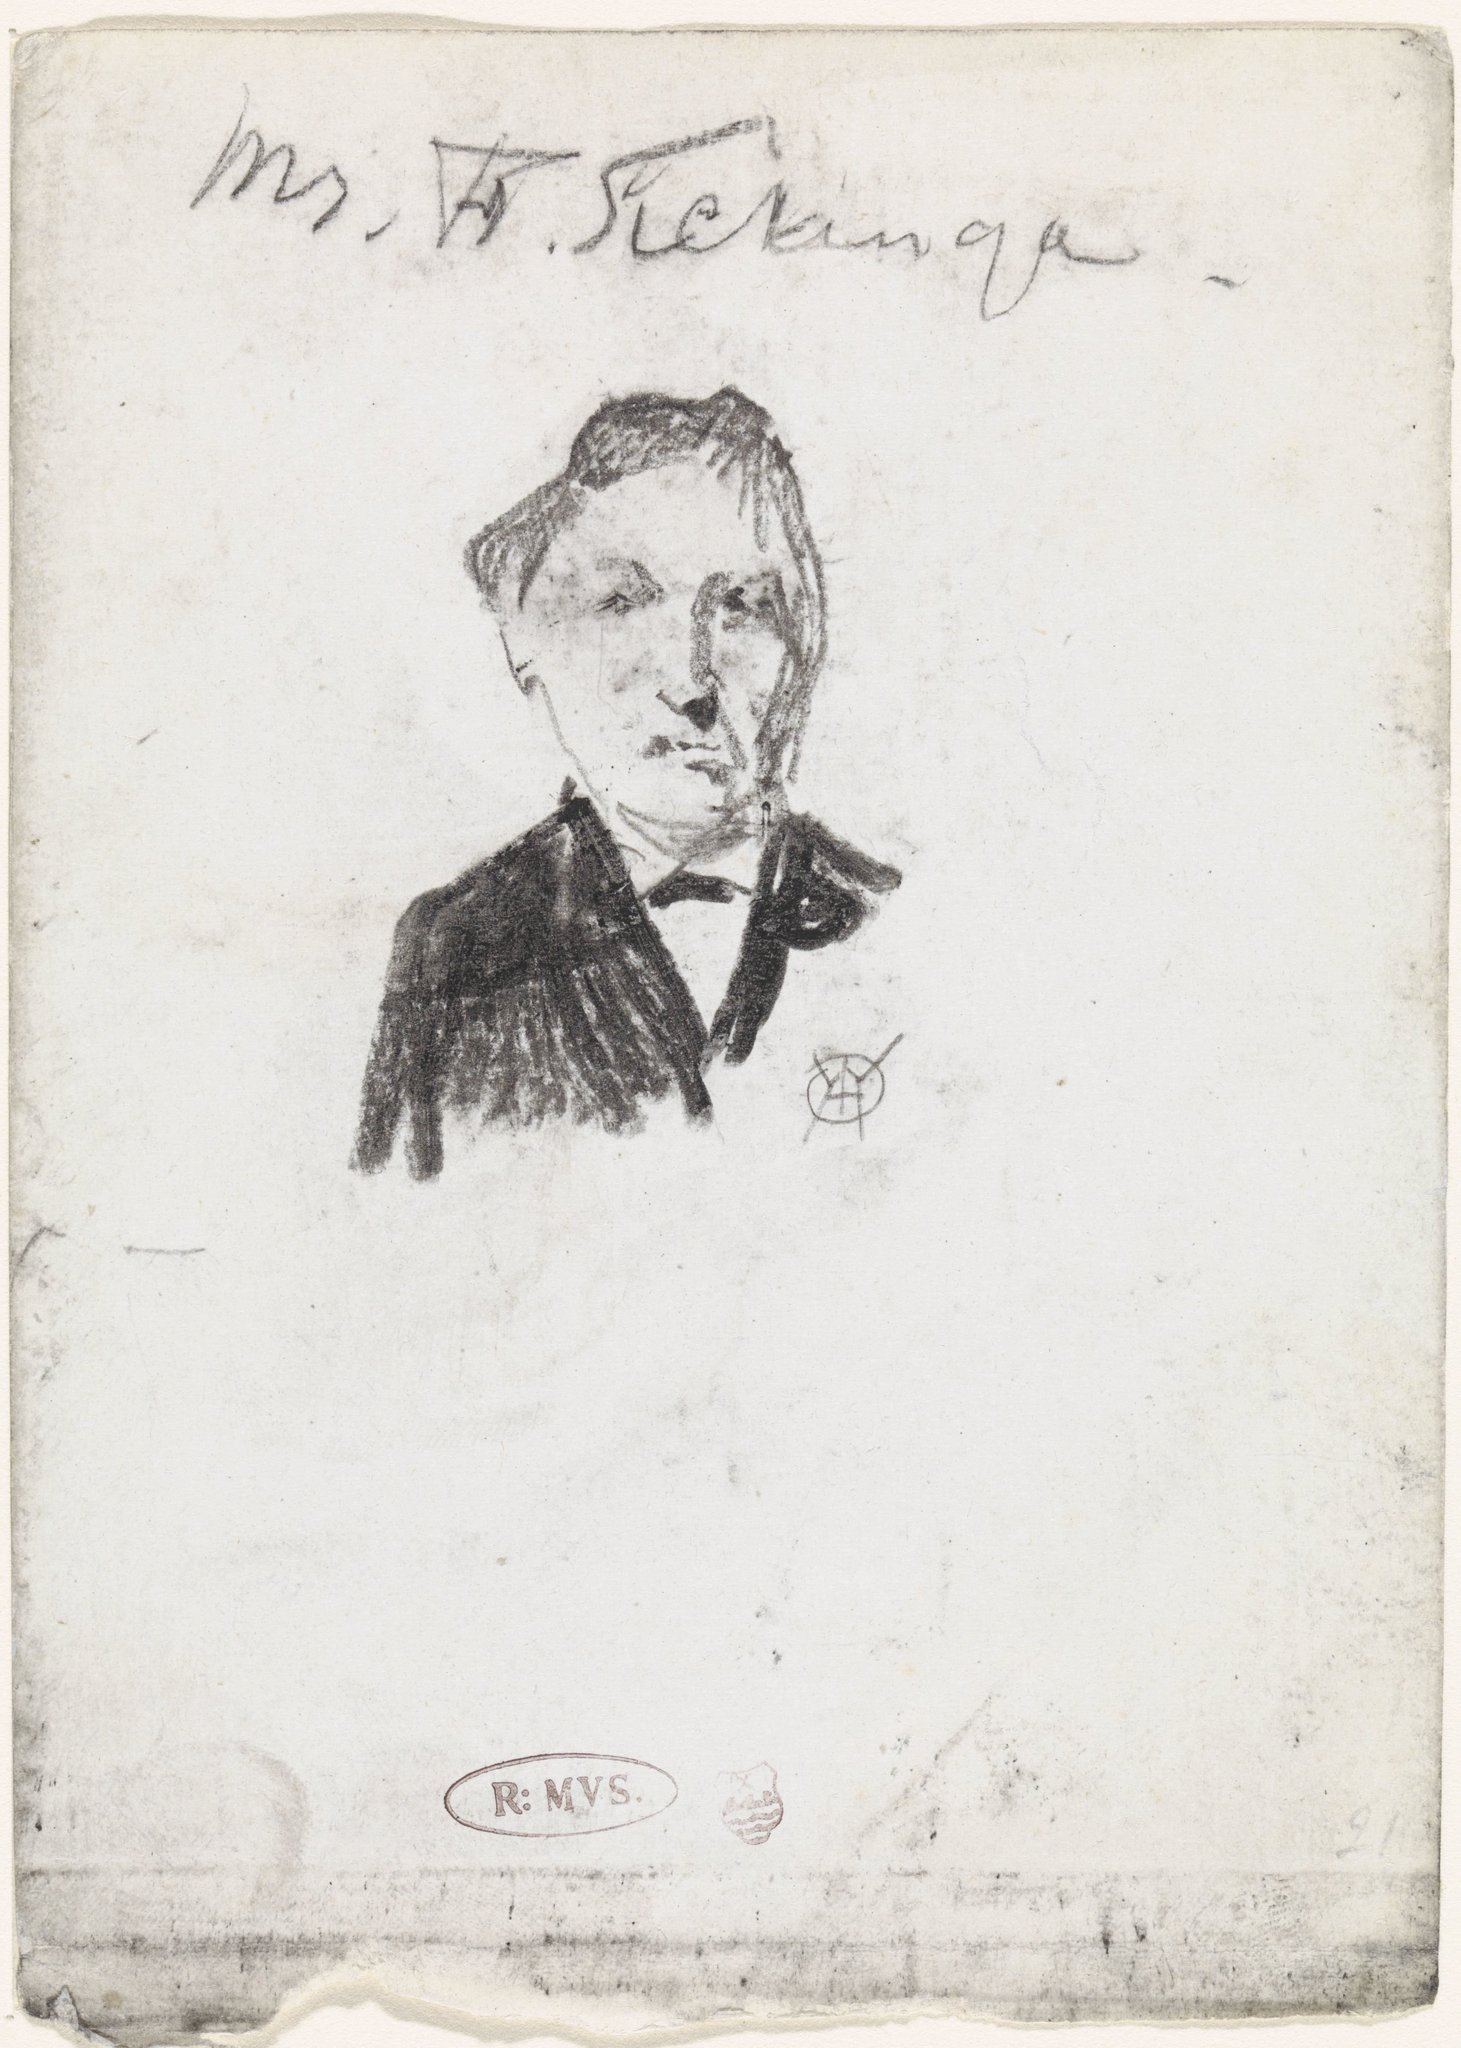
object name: drawing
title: Portret van Mr. F. Sickinga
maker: gerrit willem dijsselhof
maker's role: designer, draughtsman, print maker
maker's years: 1866-1924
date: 1876-1924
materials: chalk, paper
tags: historical persons